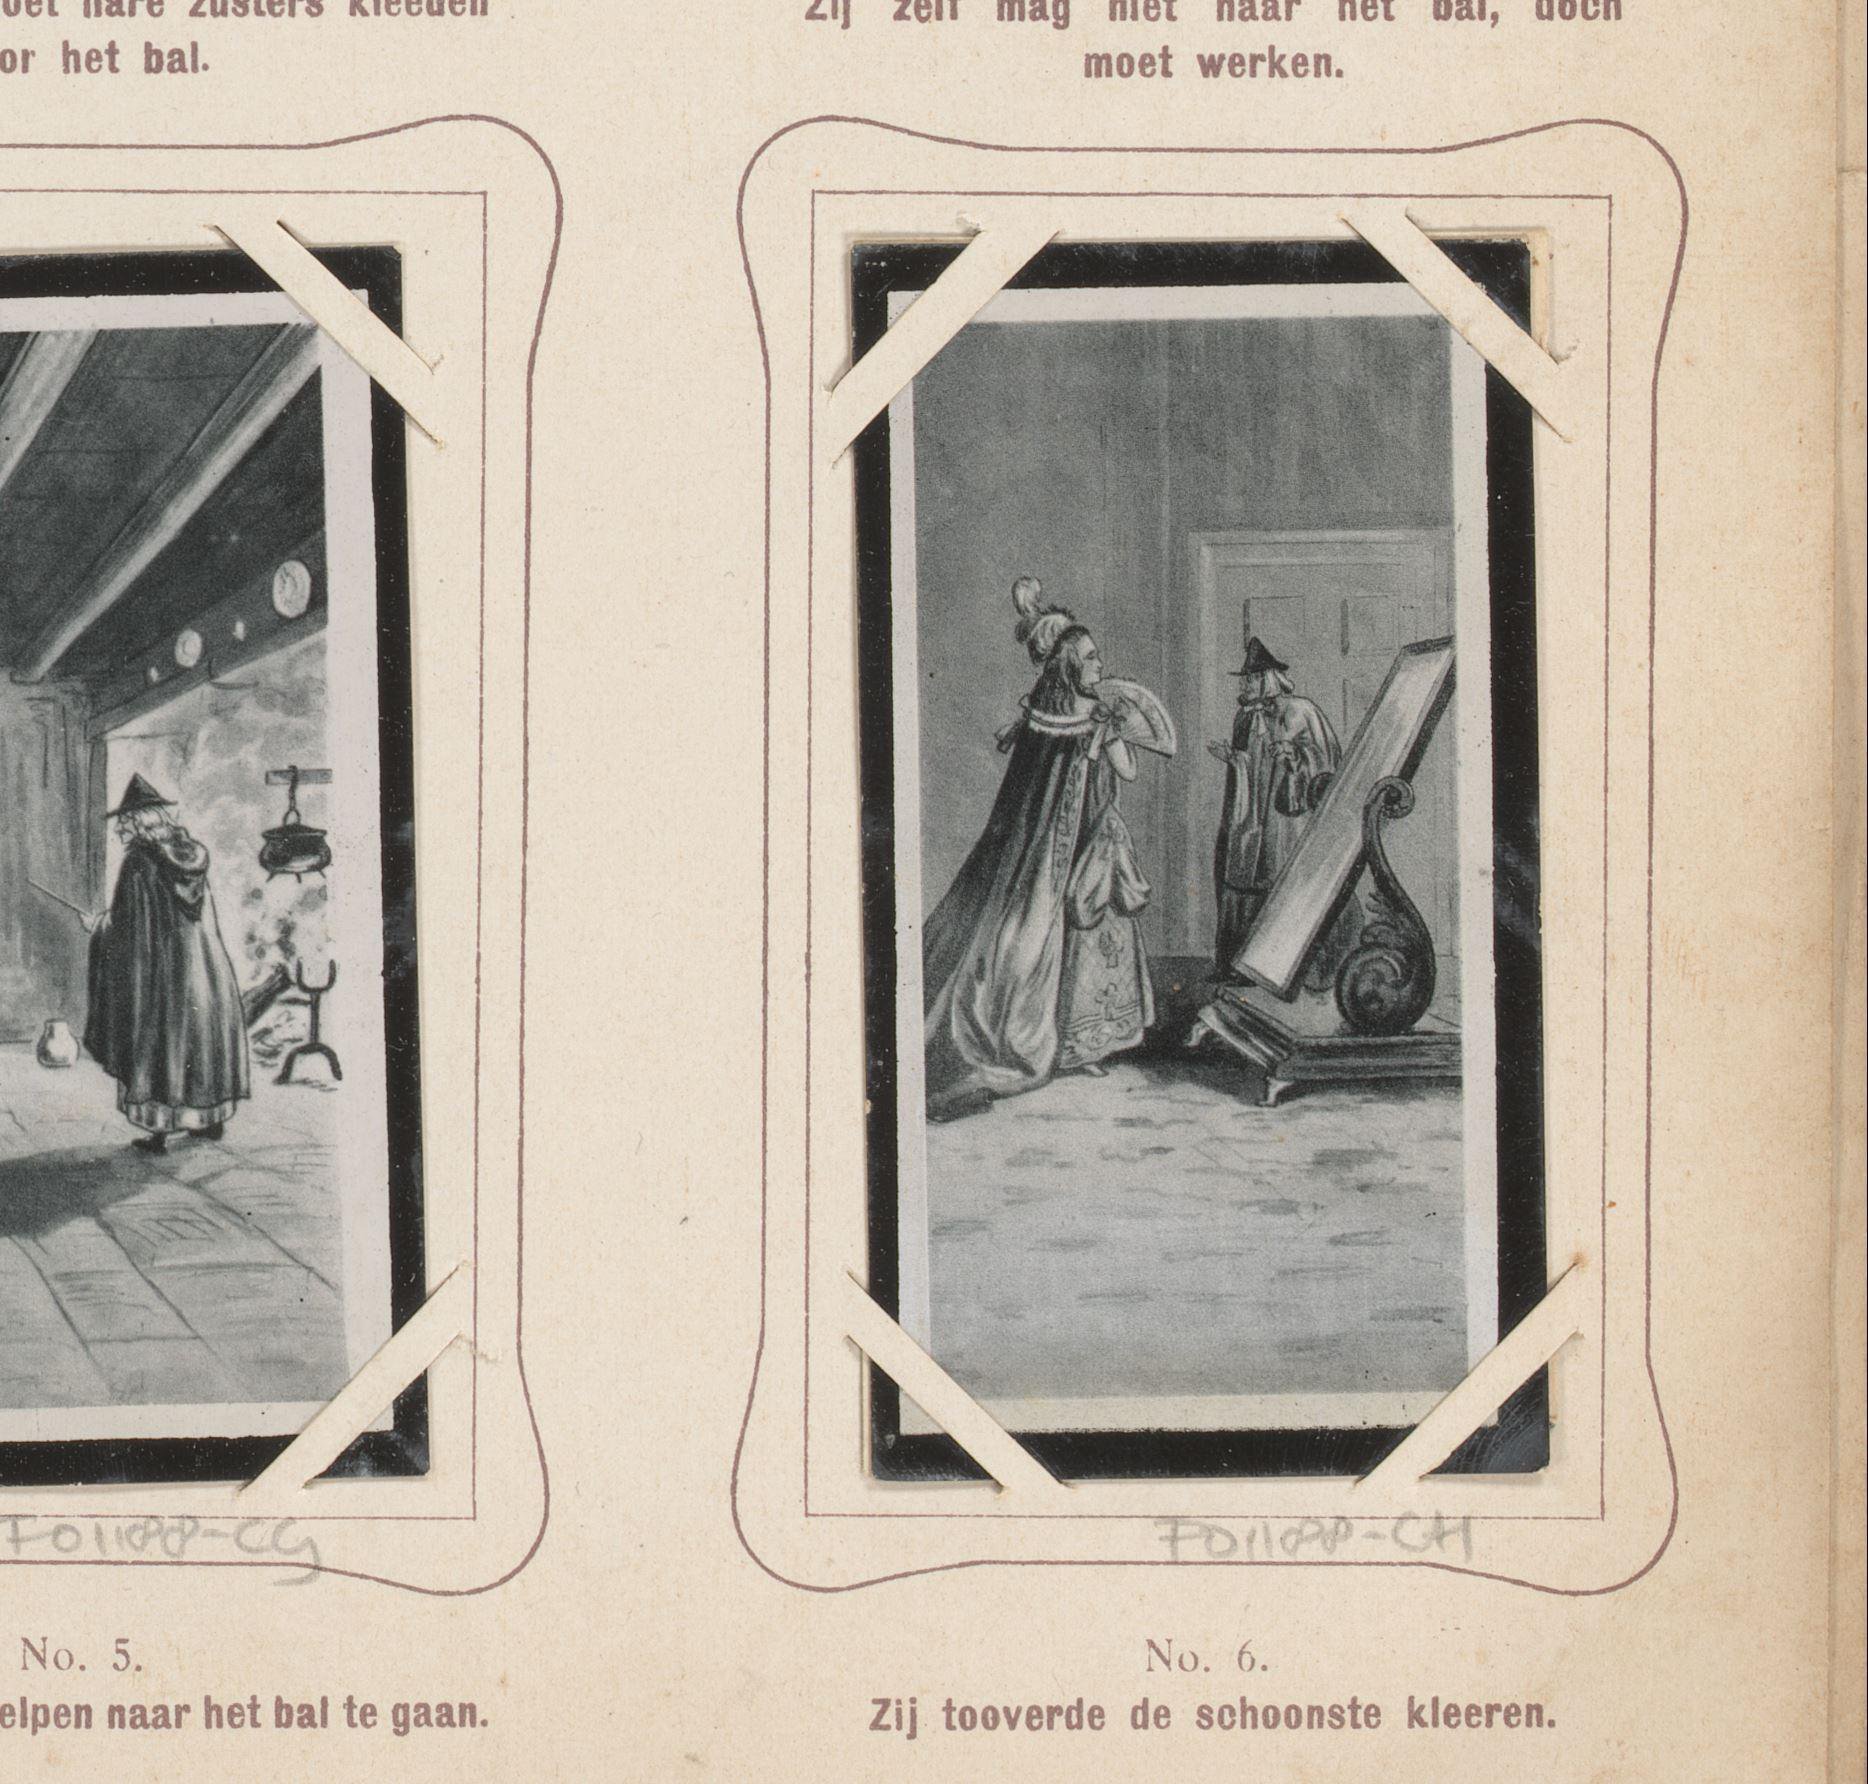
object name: album leaf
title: Reproductie van een tekening van de heks die mooie kleren tovert voor Assepoester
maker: Anonymous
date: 1906-1907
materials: paper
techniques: photograph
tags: tales and fairy tales (with title)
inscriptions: inscription: ‘No. 6./ Zij tooverde de schoonste kleeren.’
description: Deze prent maakt deel uit van een album.